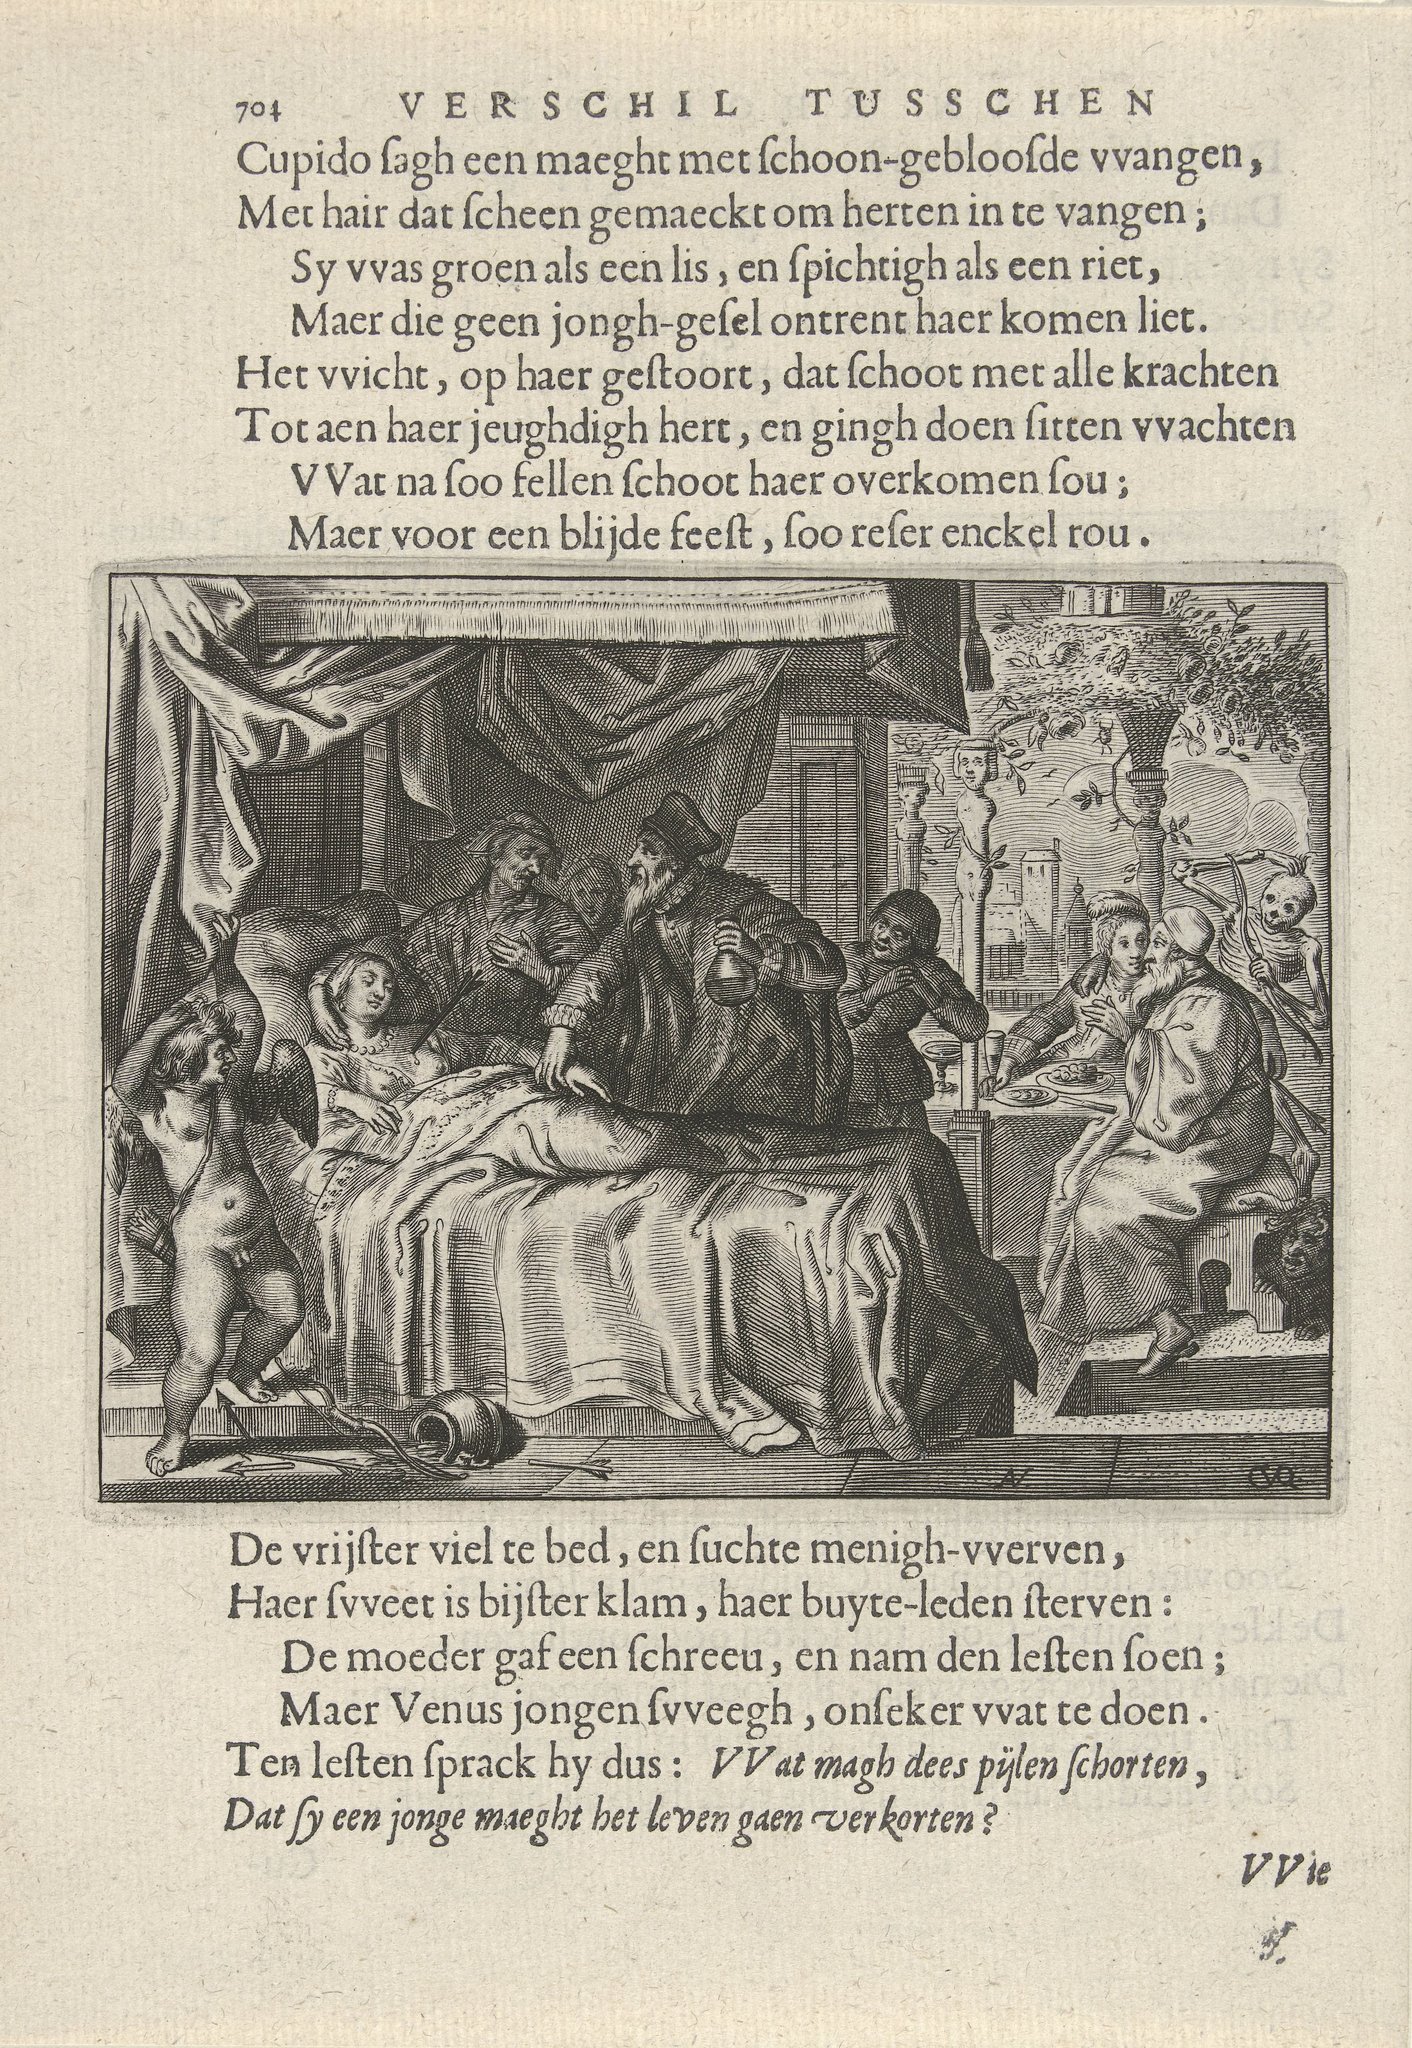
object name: print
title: Cupido en een stervende maagd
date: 1637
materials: paper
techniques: engraving, letterpress printing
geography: the hague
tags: cupid shooting a dart, physician, doctor, death as skeleton - ff - death as female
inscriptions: collector's mark: Lugt 2228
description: Cupido heeft een pijl in het hart van een jonge vrouw geschoten en kijkt geschrokken toe hoe zij sterft. Een dokter voelt haar pols en houdt een fles met vloeistof in zijn hand. Op de achtergrond een tafelend liefdespaar, waarvan de man een pijl, die de dood op hem afvuurde, in zijn rug heeft. De Dood krabt verbaast op zijn schedel omdat de geraakte man niet dood neervalt maar verliefd is. Uit de tekst bij de prent blijkt dat de pijlenbundels van Cupido en de Dood verwisseld zijn waardoor de jonge vrouw sterft en de oude man verliefd is.